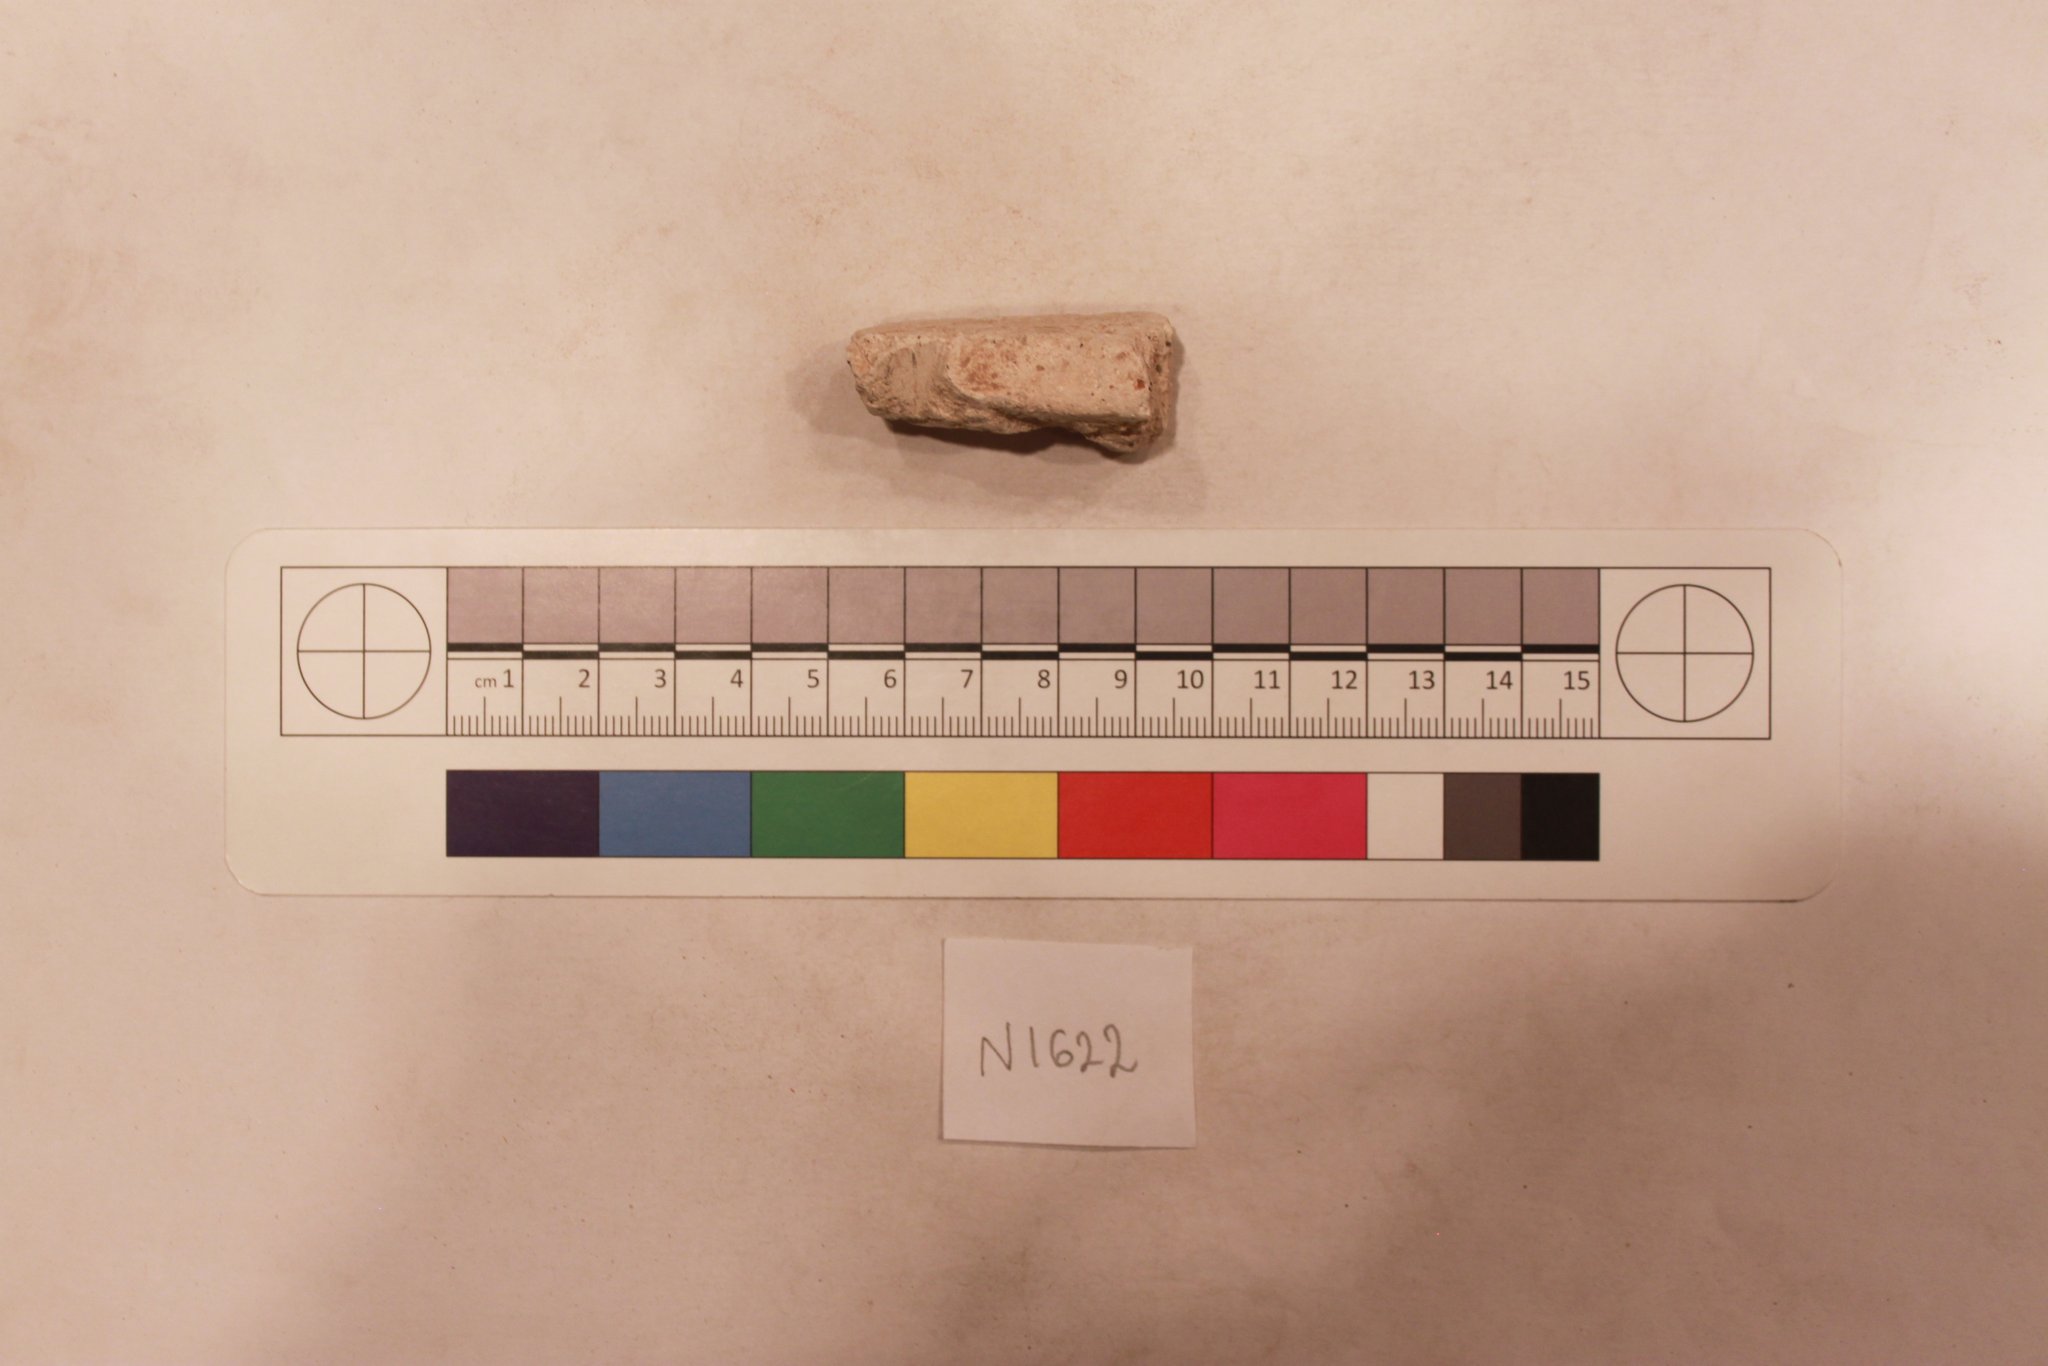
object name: fragment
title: Stucco Fragment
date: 701-1200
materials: plaster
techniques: carving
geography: iran